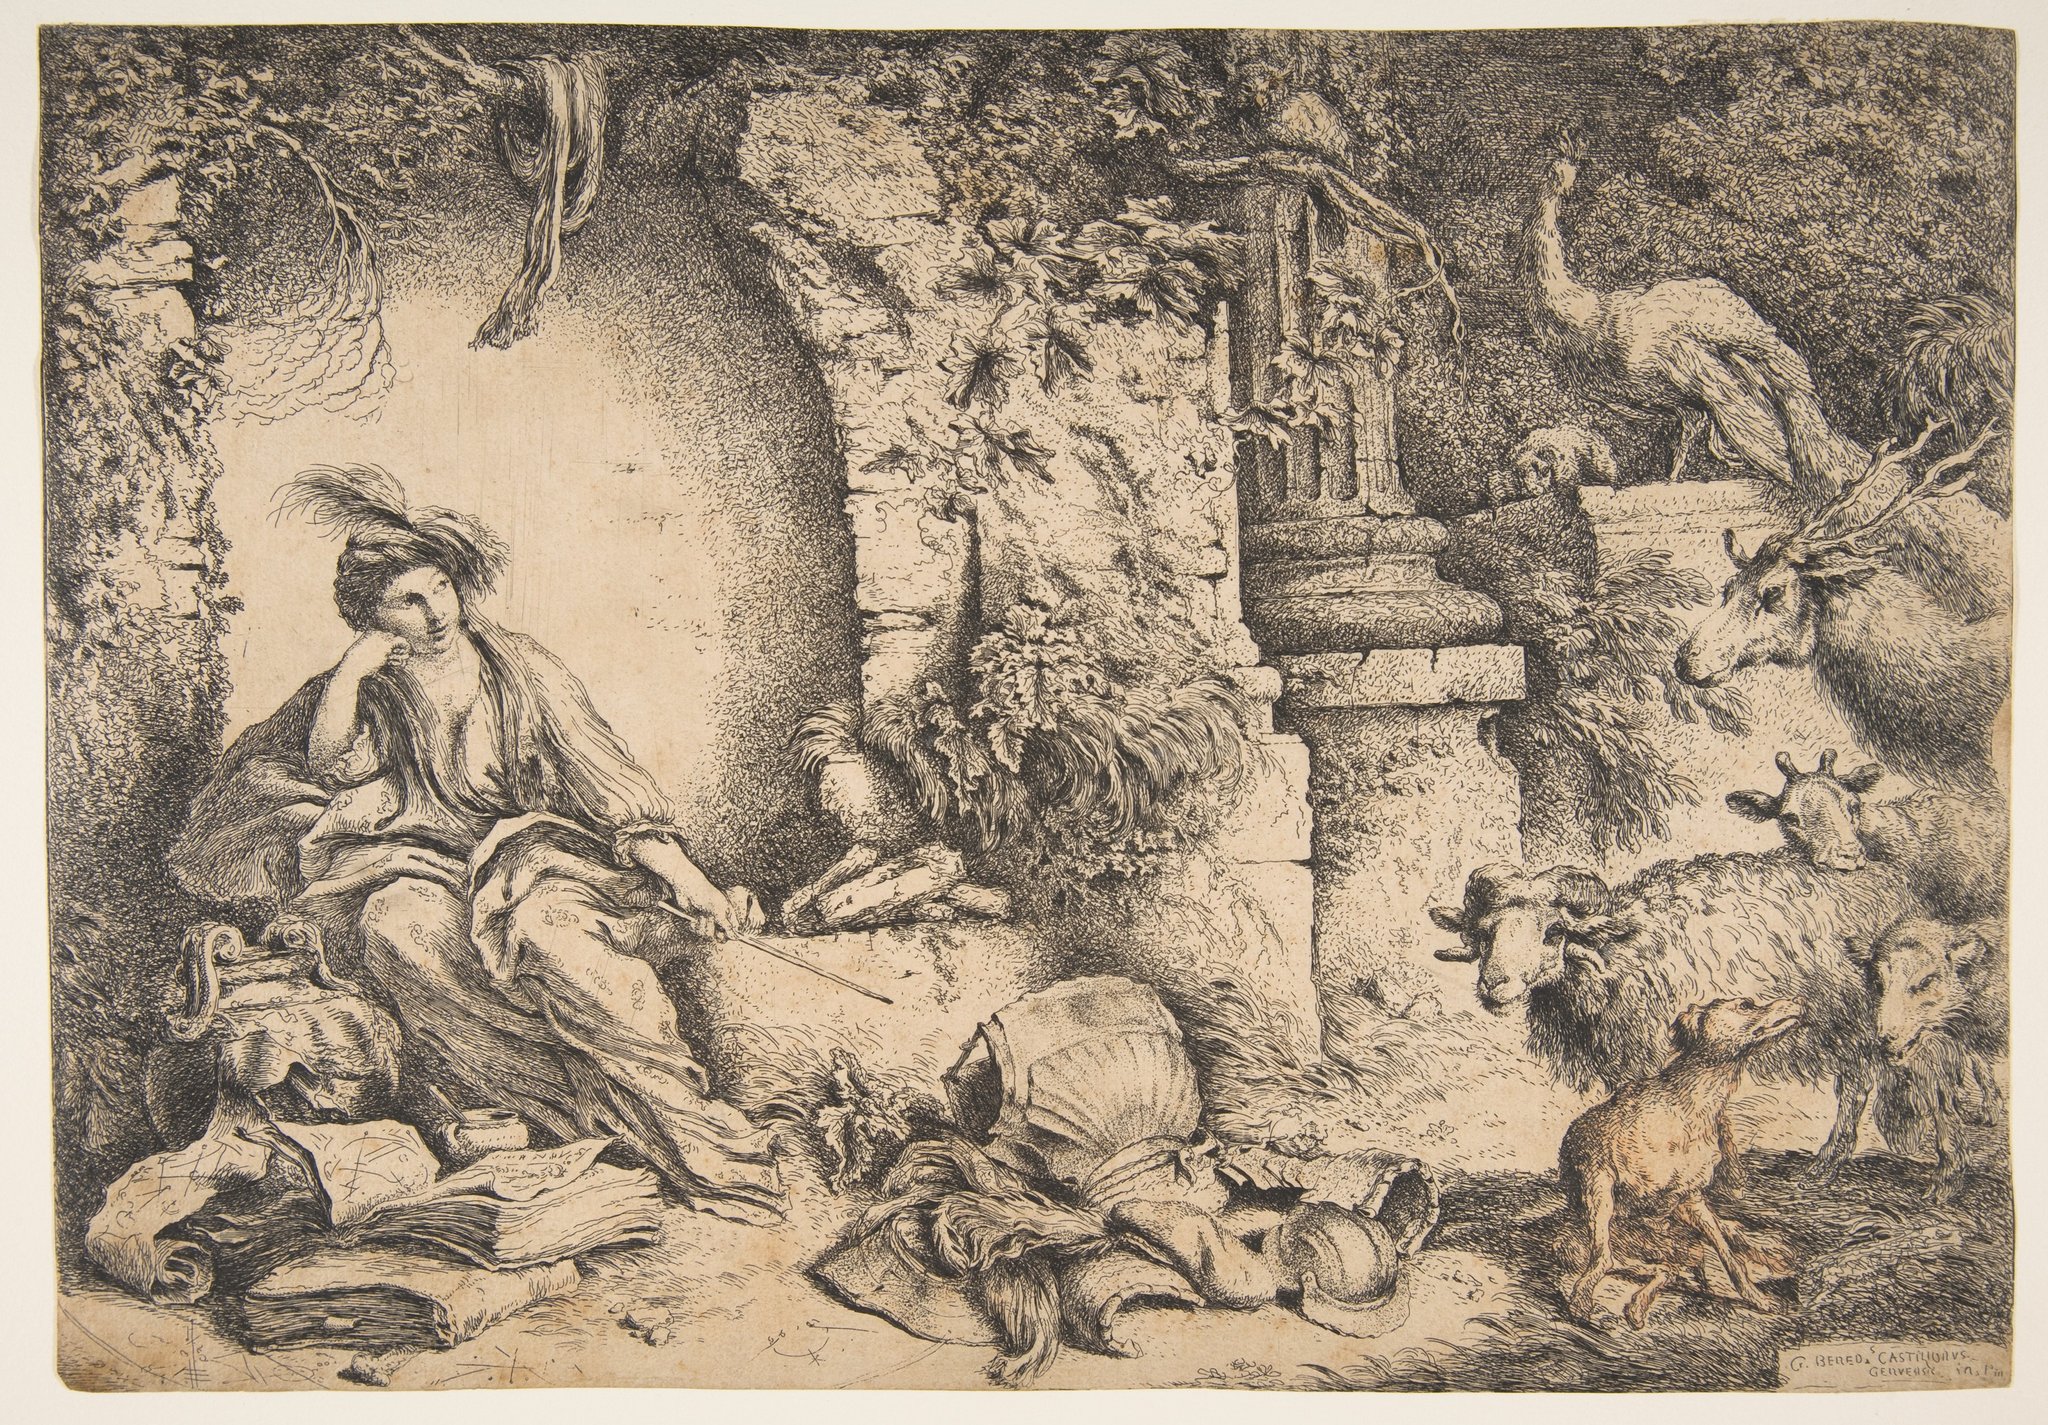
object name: print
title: Circe with the companions of Ulysses changed into animals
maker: giovanni benedetto castiglione (il grechetto)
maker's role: artist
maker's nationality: italian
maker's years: 1609-1664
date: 1650-1651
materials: chalk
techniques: etching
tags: ruins,women,peacocks,deer,sheep